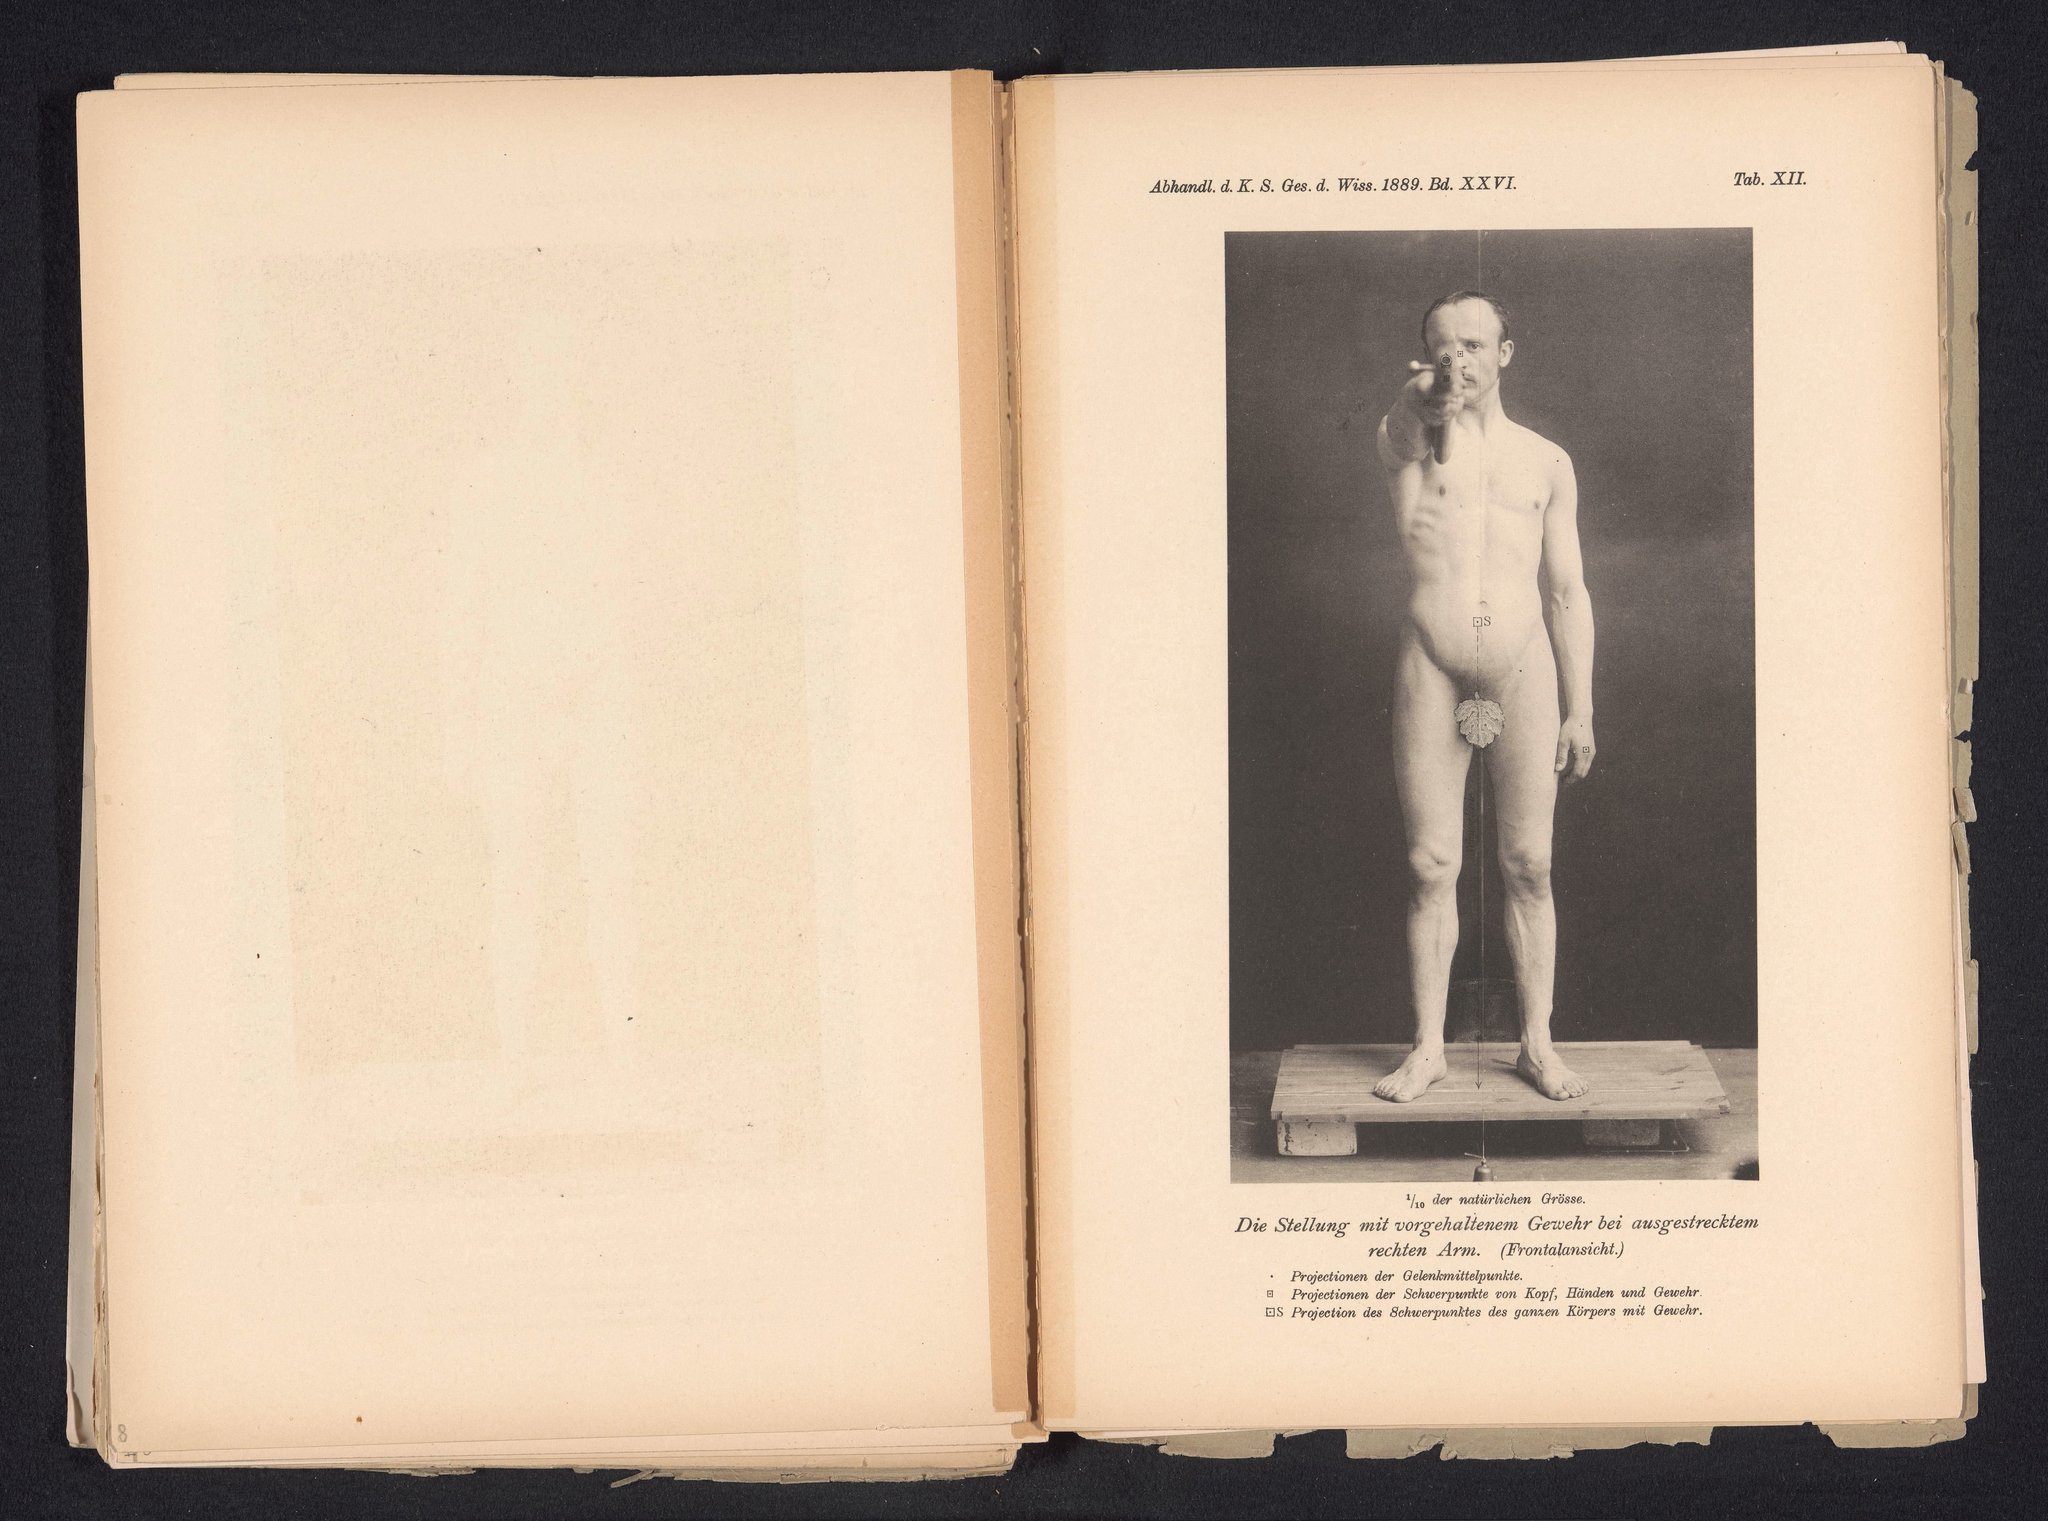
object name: page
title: Onbekende naakte man, en face met een geweer in zijn rechterhand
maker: Anonymous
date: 1880-1890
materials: paper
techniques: photograph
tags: anatomy (non-medical), firearms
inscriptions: inscription: ‘Schwerlinie. 1/10 der natürlichen Grösse. Projectionen der Gelenkmittelpunkte. Projectionen der Schwerpunkte von Kopf, Händen und Gewehr. Projection des Schwerpunkte des ganzen Körpers mit Gewehr.’, number: ‘Tab. XII.’